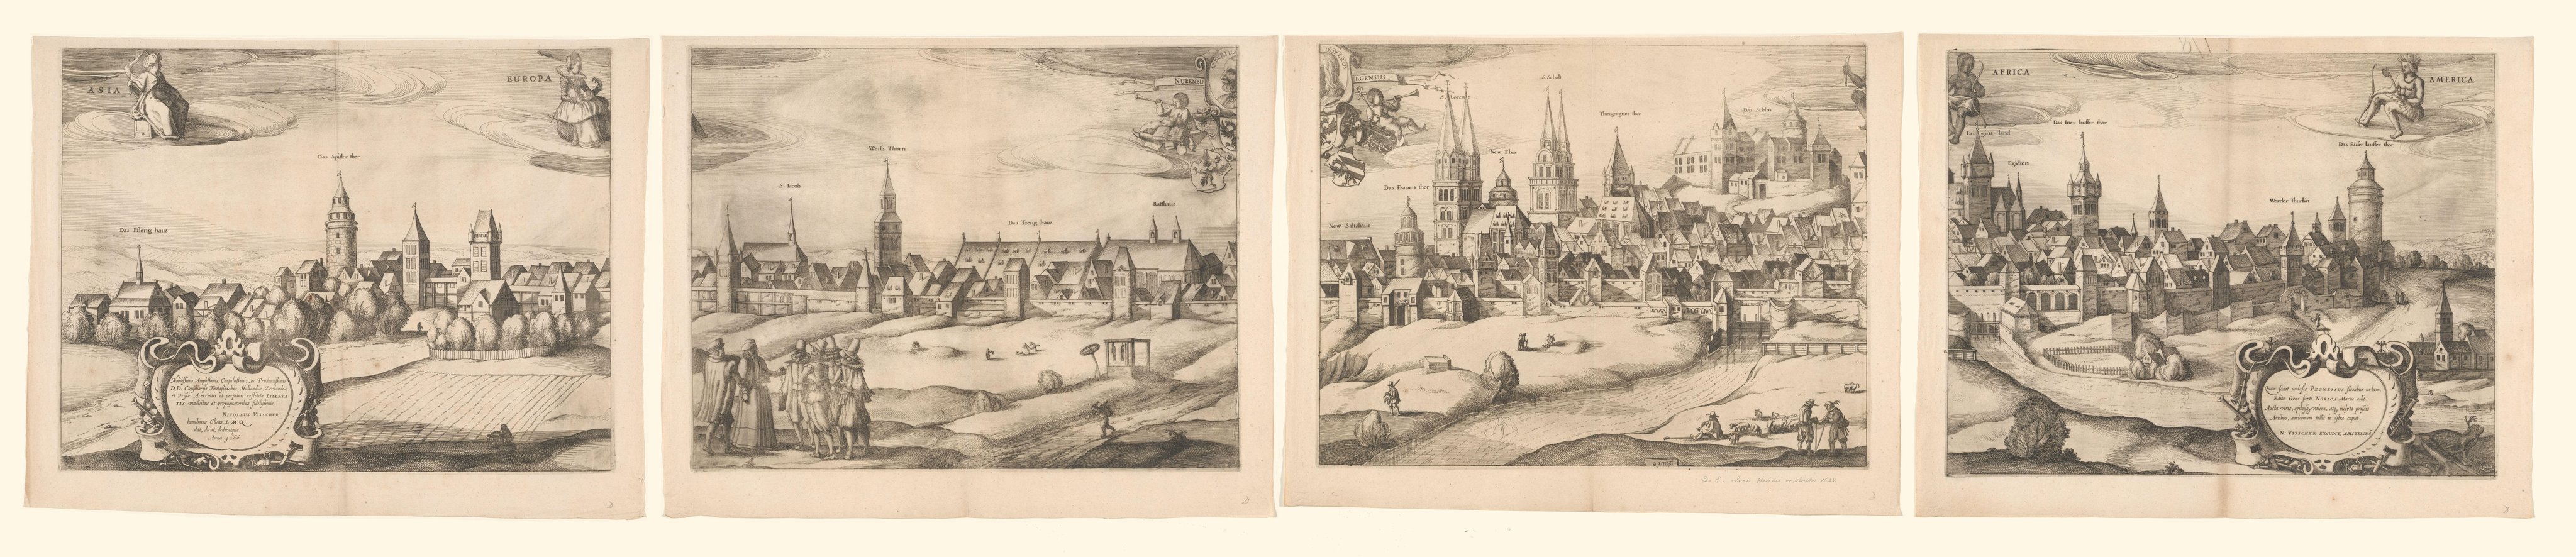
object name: print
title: Gezicht op Neurenberg, bestaande uit vier delen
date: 1666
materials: paper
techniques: etching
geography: amsterdam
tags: painter, print maker, draughtsman, albrecht dürer, city-view, and landscape with man-made constructions, europe represented allegorically; 'europa' (ripa), asia represented allegorically; 'asia' (ripa), africa represented allegorically; 'africa' (ripa), america represented allegorically; 'america' (ripa), castle, herding, herdsman, herdswoman, shepherd, shepherdess, cowherd, etc., violent death by hanging, church (exterior), landscape with tower or castle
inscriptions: collector's mark: Lugt 2228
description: Gezicht op Neurenberg, bestaande uit vier delen, met verschillende kerken, torens en een slot. In de lucht boven de stad zetelen de personificaties van Azië en Europa, Afrika en Amerika. Buiten de stadsmuren onder meer een groep welgestelde heren en een vrouw, aan twee balken opgehangen figuren, een herder met zijn kudde en wandelaars. Geheel boven een portret van Albrecht Dürer.